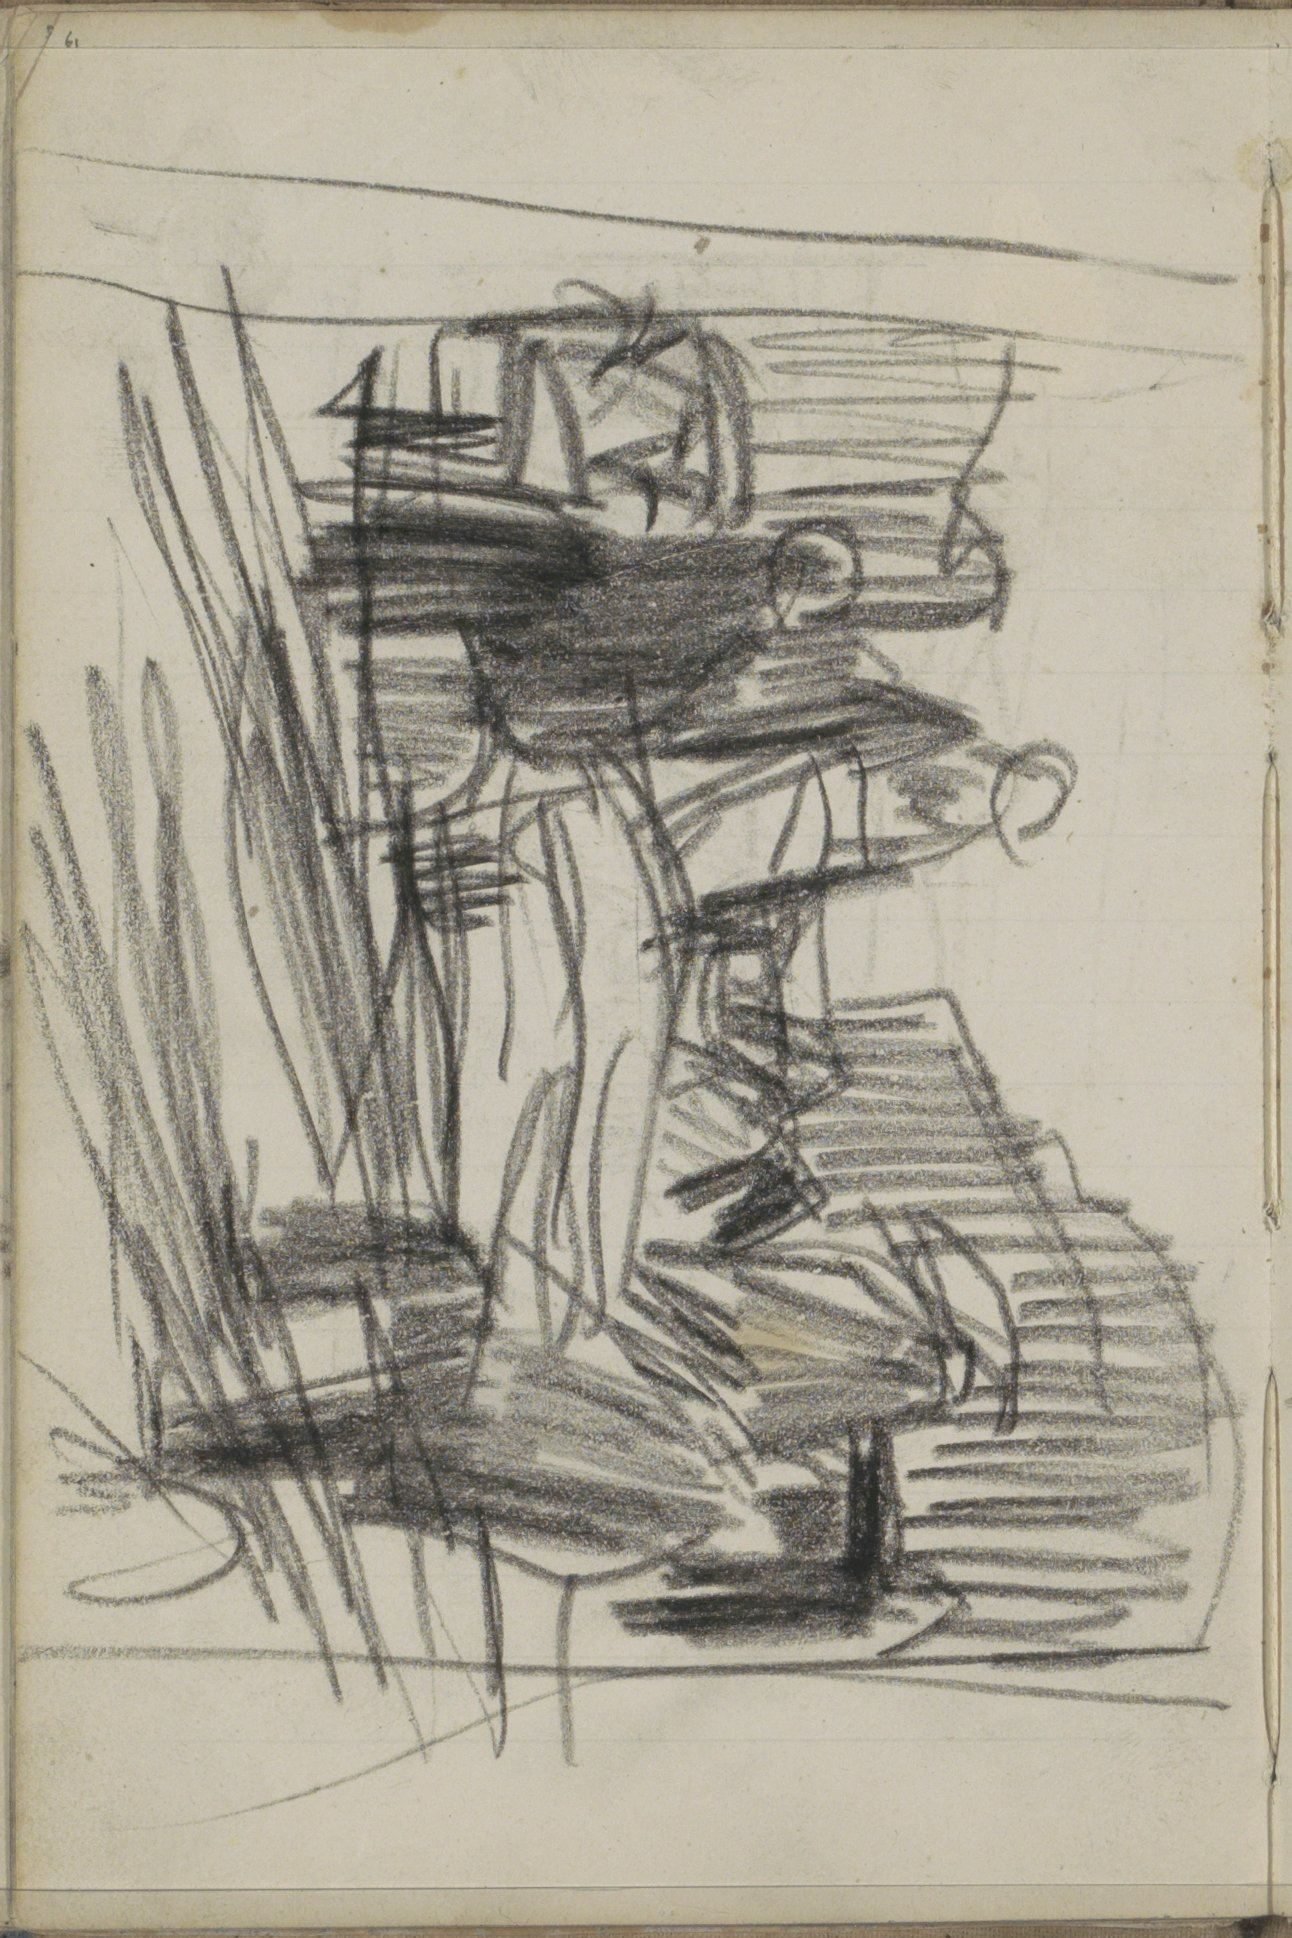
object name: sketchbook leaf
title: Figuren bij een gebouw met koepeldak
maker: marius bauer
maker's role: draughtsman, print maker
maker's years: 1867-1932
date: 1888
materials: chalk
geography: istanbul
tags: asiatic races and peoples, dome ~ architecture, street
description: De figuren staan of zitten, mogelijk bij een moskee. Pagina 61 uit een schetsboek met 58 bladen.